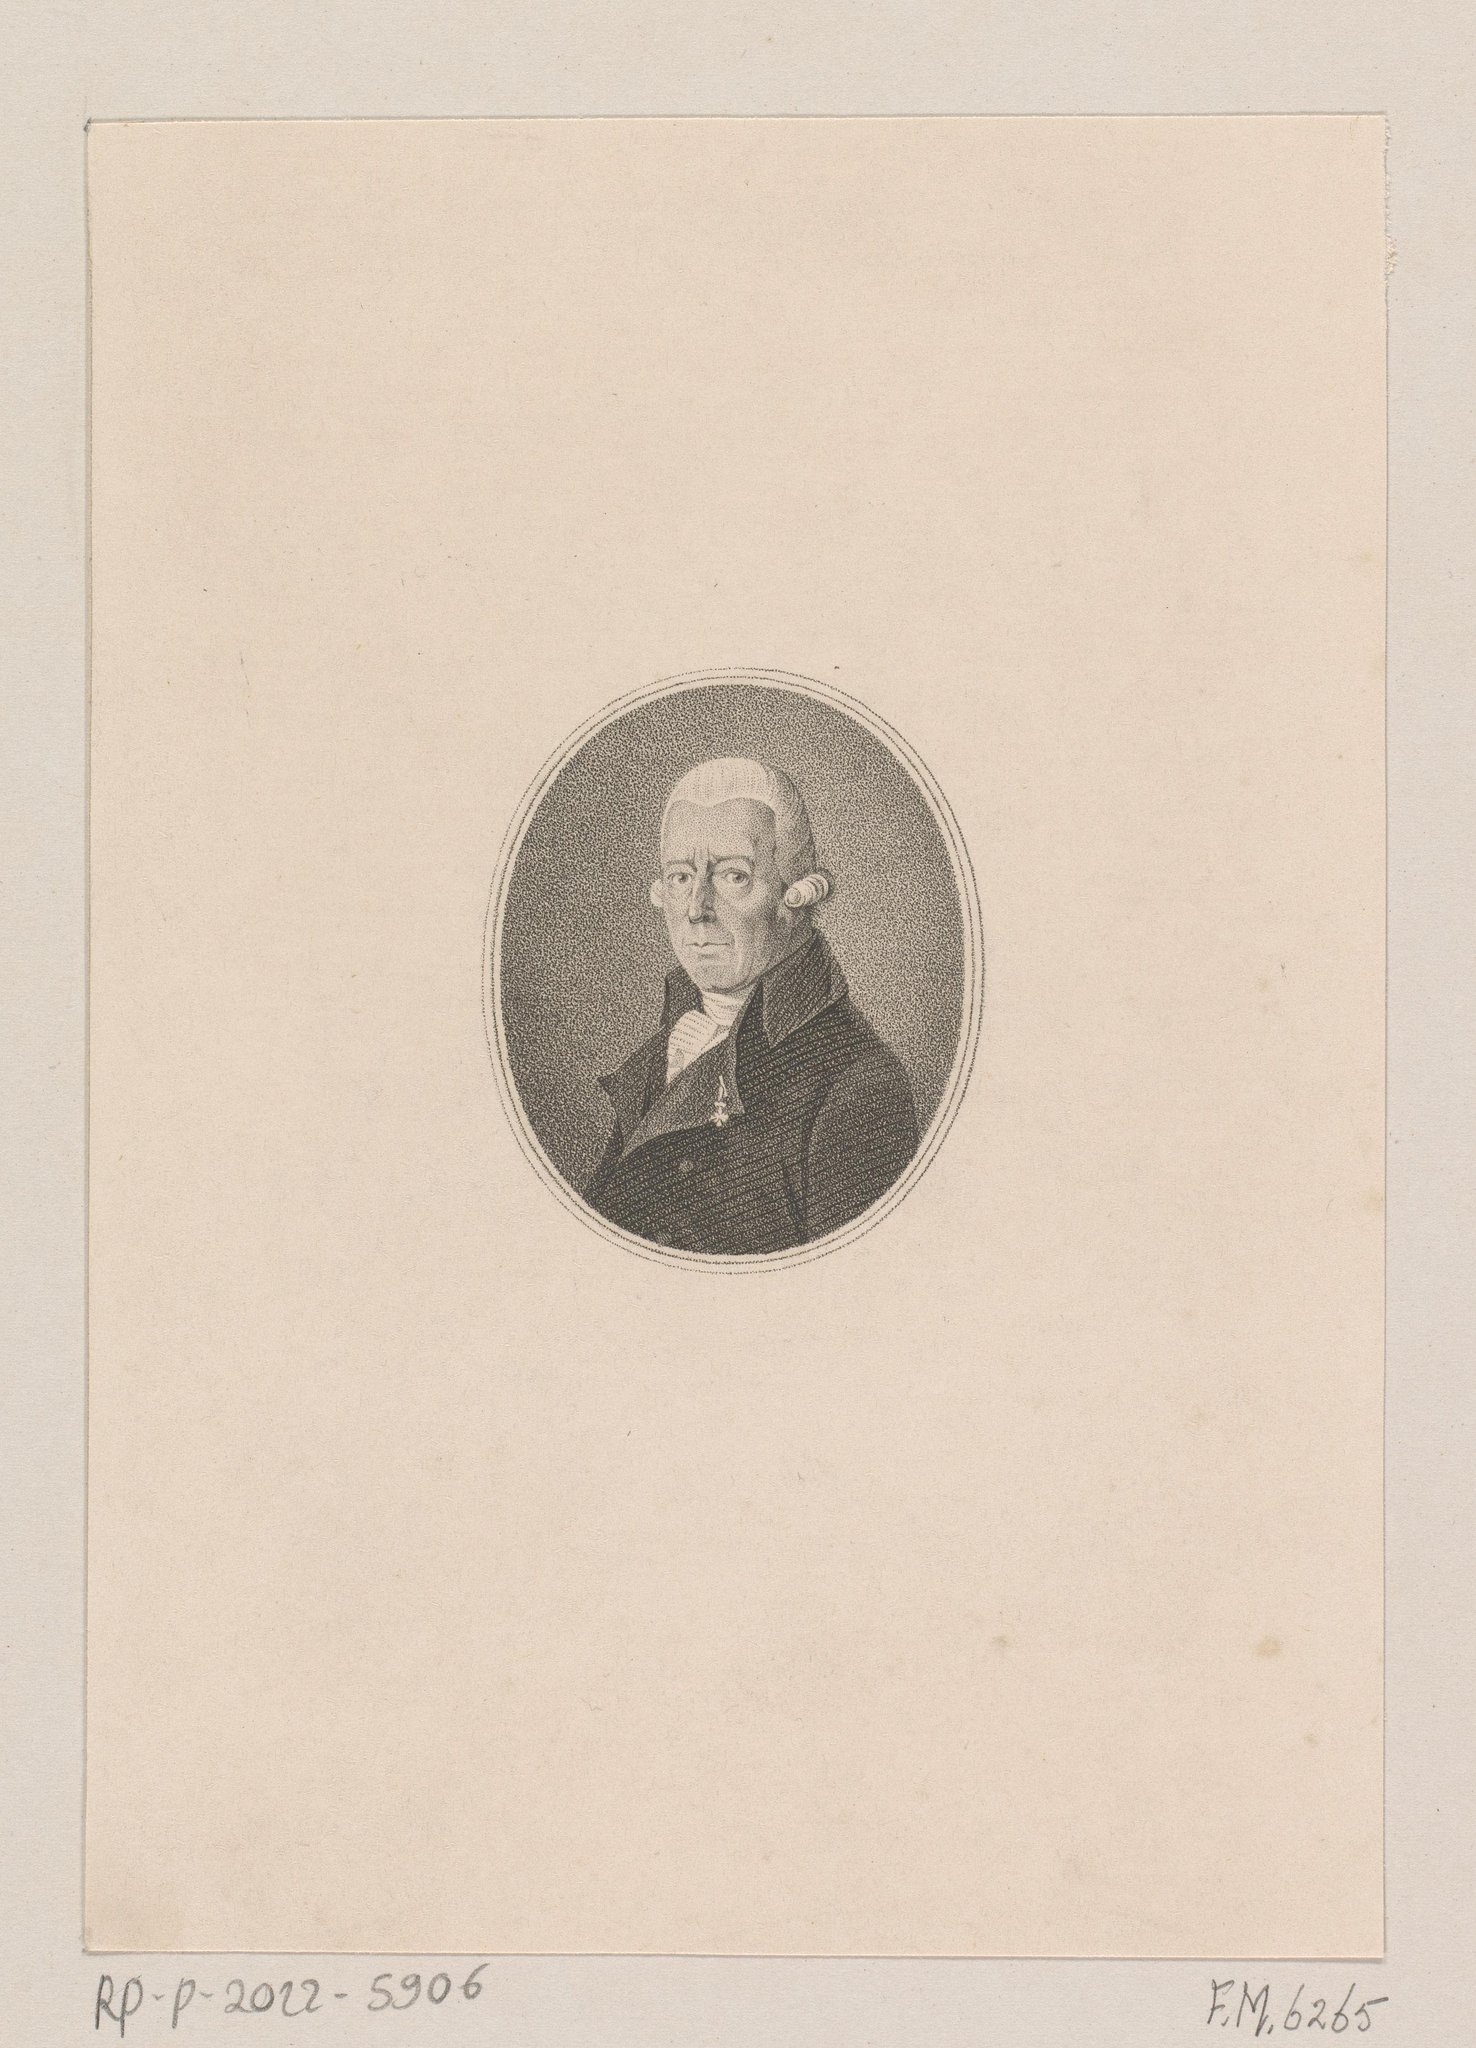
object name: book illustration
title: Portret van Hendrik van Wijn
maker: Anonymous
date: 1832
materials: paper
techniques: lithograph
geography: amsterdam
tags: the hague, draughtsman, hendrik van wijn, historical persons, lawyer, attorney at law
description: Prent waarschijnlijk uit: Jonge, J.C. de. Henrik van Wyn als geleerde en staatsman geschetst. Den Haag en Amsterdam: Gebroeders van Cleef, 1832.